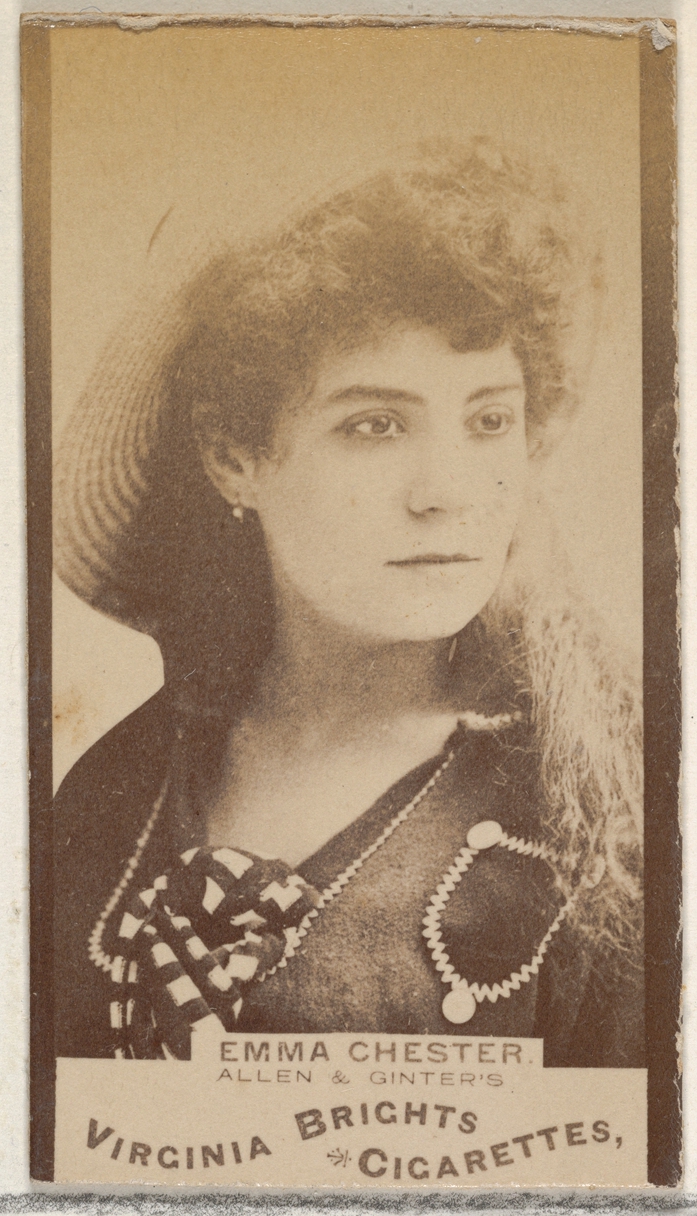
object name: photograph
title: Emma Chester, from the Actors and Actresses series (N45, Type 3) for Virginia Brights Cigarettes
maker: allen & ginter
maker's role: publisher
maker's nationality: american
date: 1888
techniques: albumen silver print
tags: portraits,women,actresses